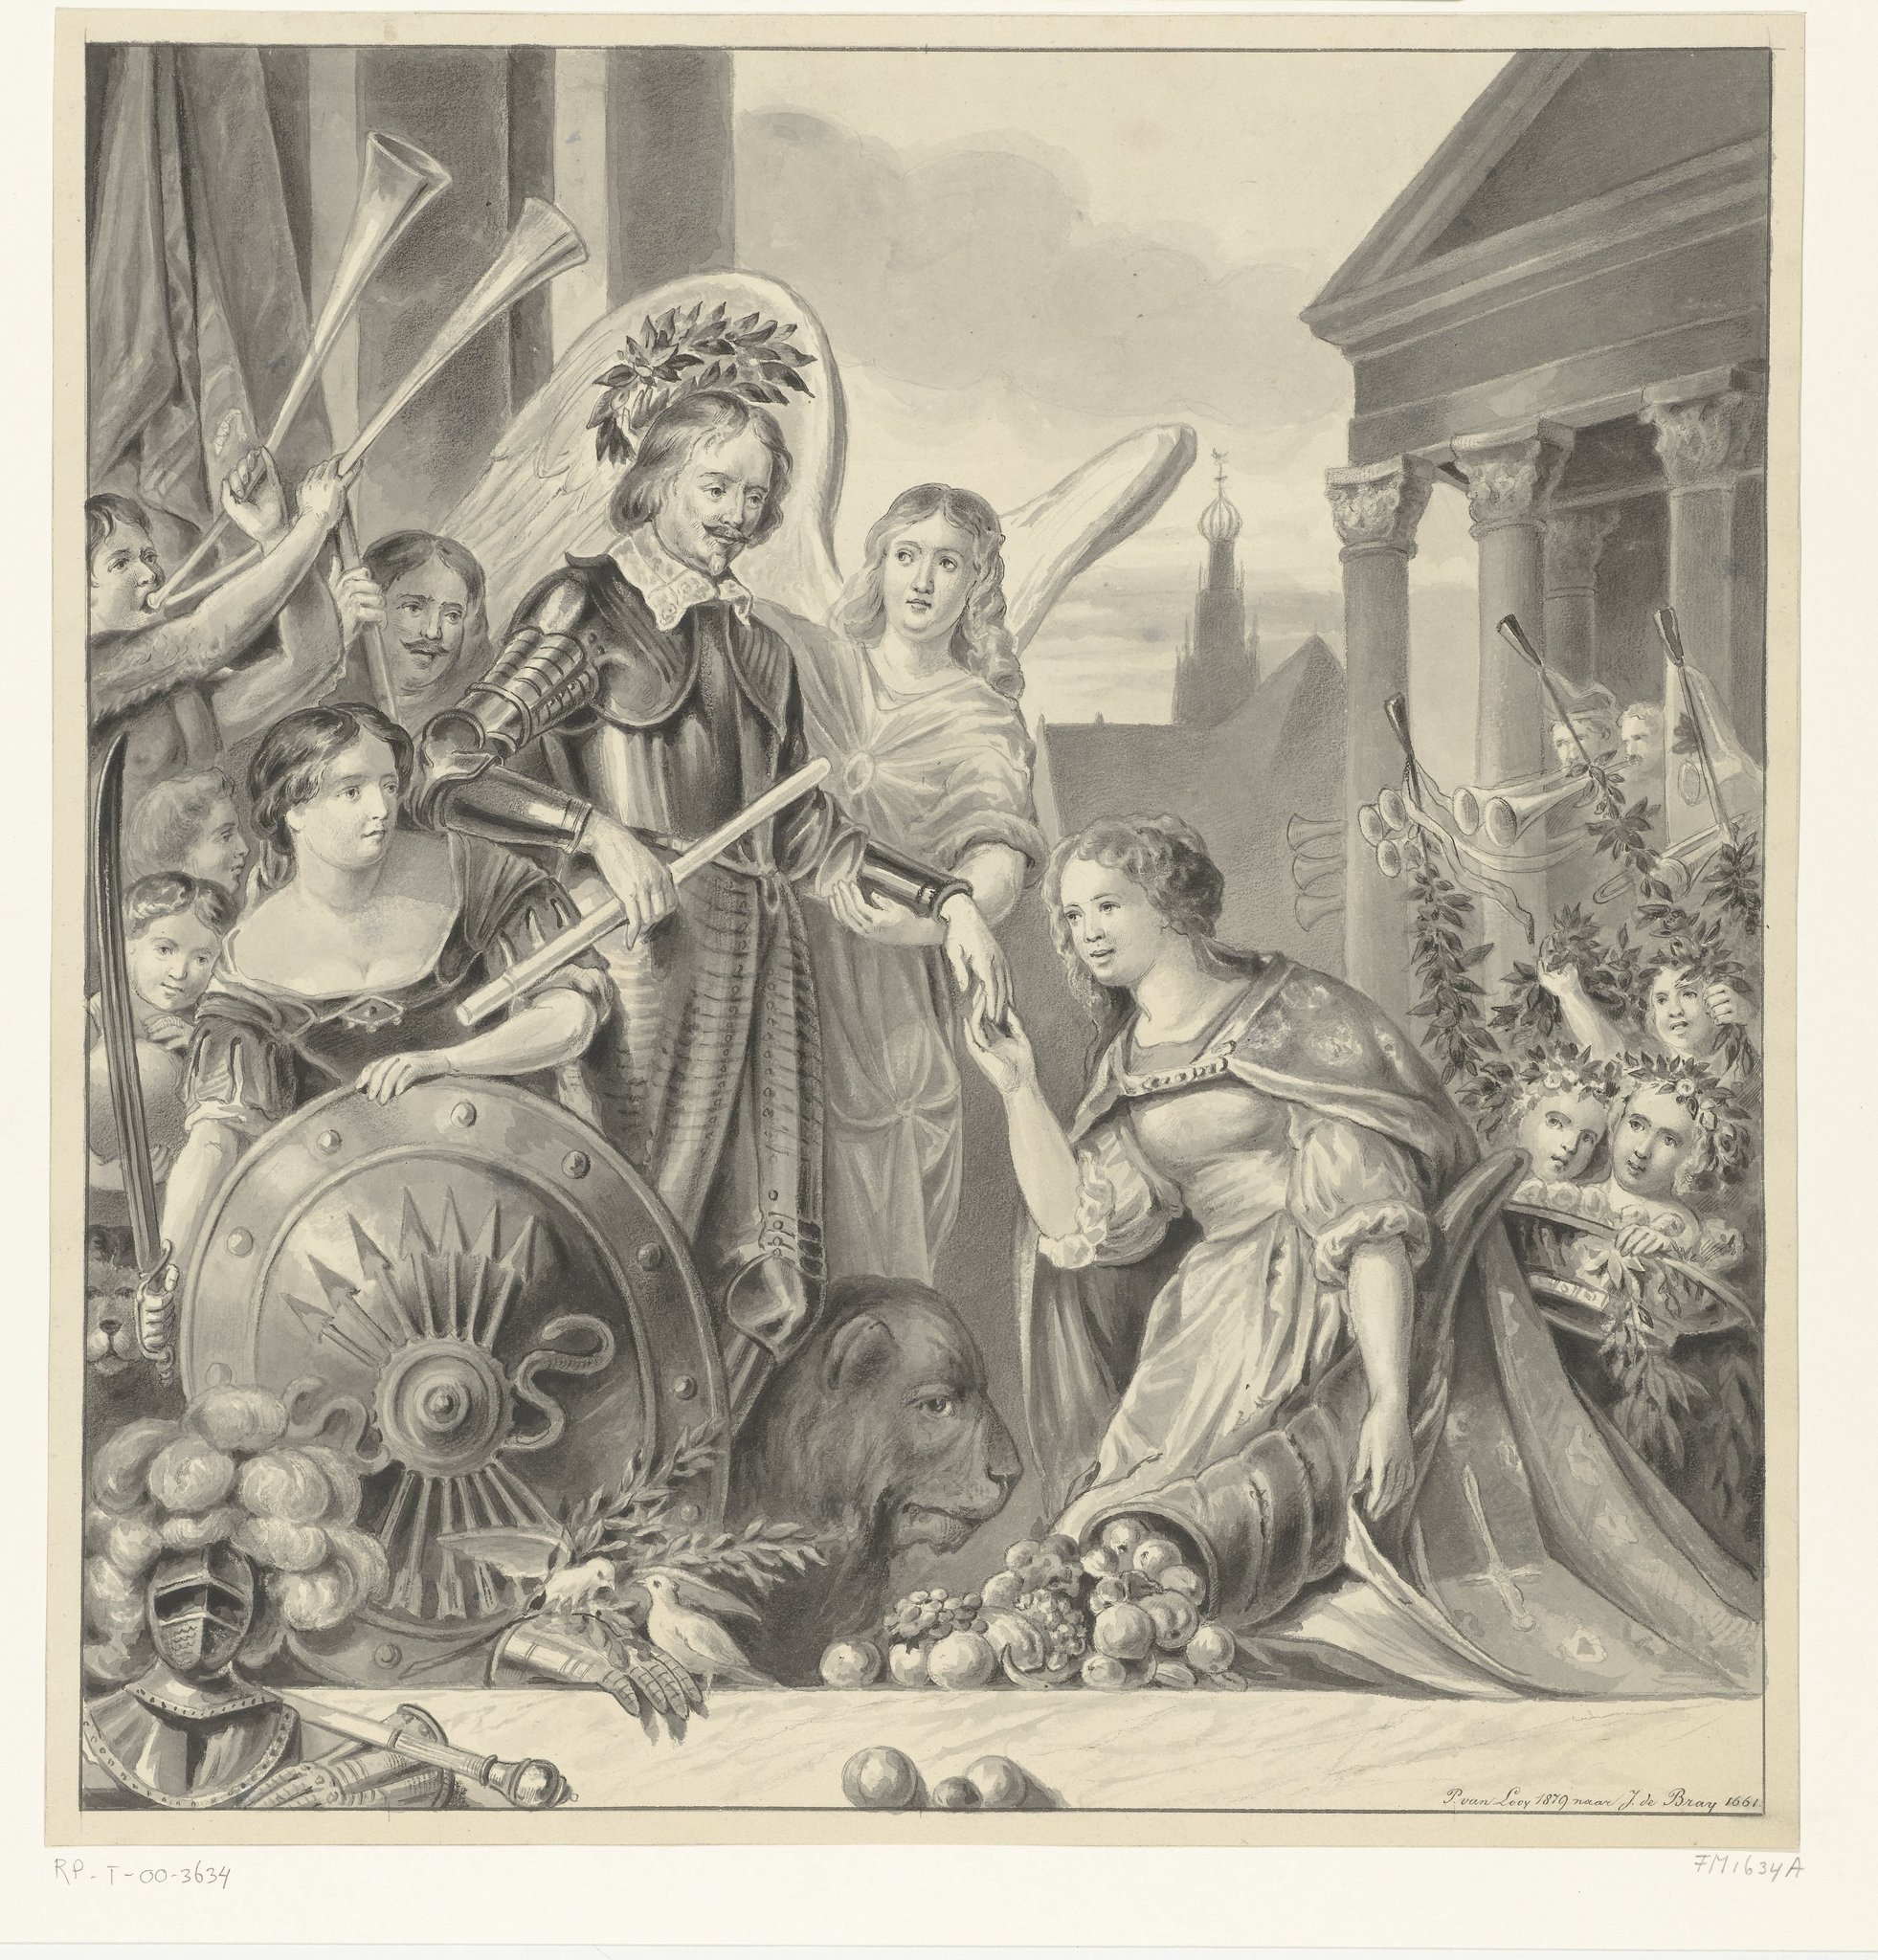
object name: drawing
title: De stadsmaagd van Haarlem knielend voor Frederik Hendrik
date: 1879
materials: paper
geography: netherlands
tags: delft, the hague, frederick henry (prince of orange), personification of a city, town-patron(ess), triumphs (allegorical and symbolic), haarlem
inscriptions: date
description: Allegorie met stadhouder Frederik Hendrik als brenger van vrede en welvaart te Haarlem. De stadsmaagd van Haarlem met hoorn van overvloed knielend voor Frederik Hendrik. Op de achtergrond de Sint Bavo van Haarlem.